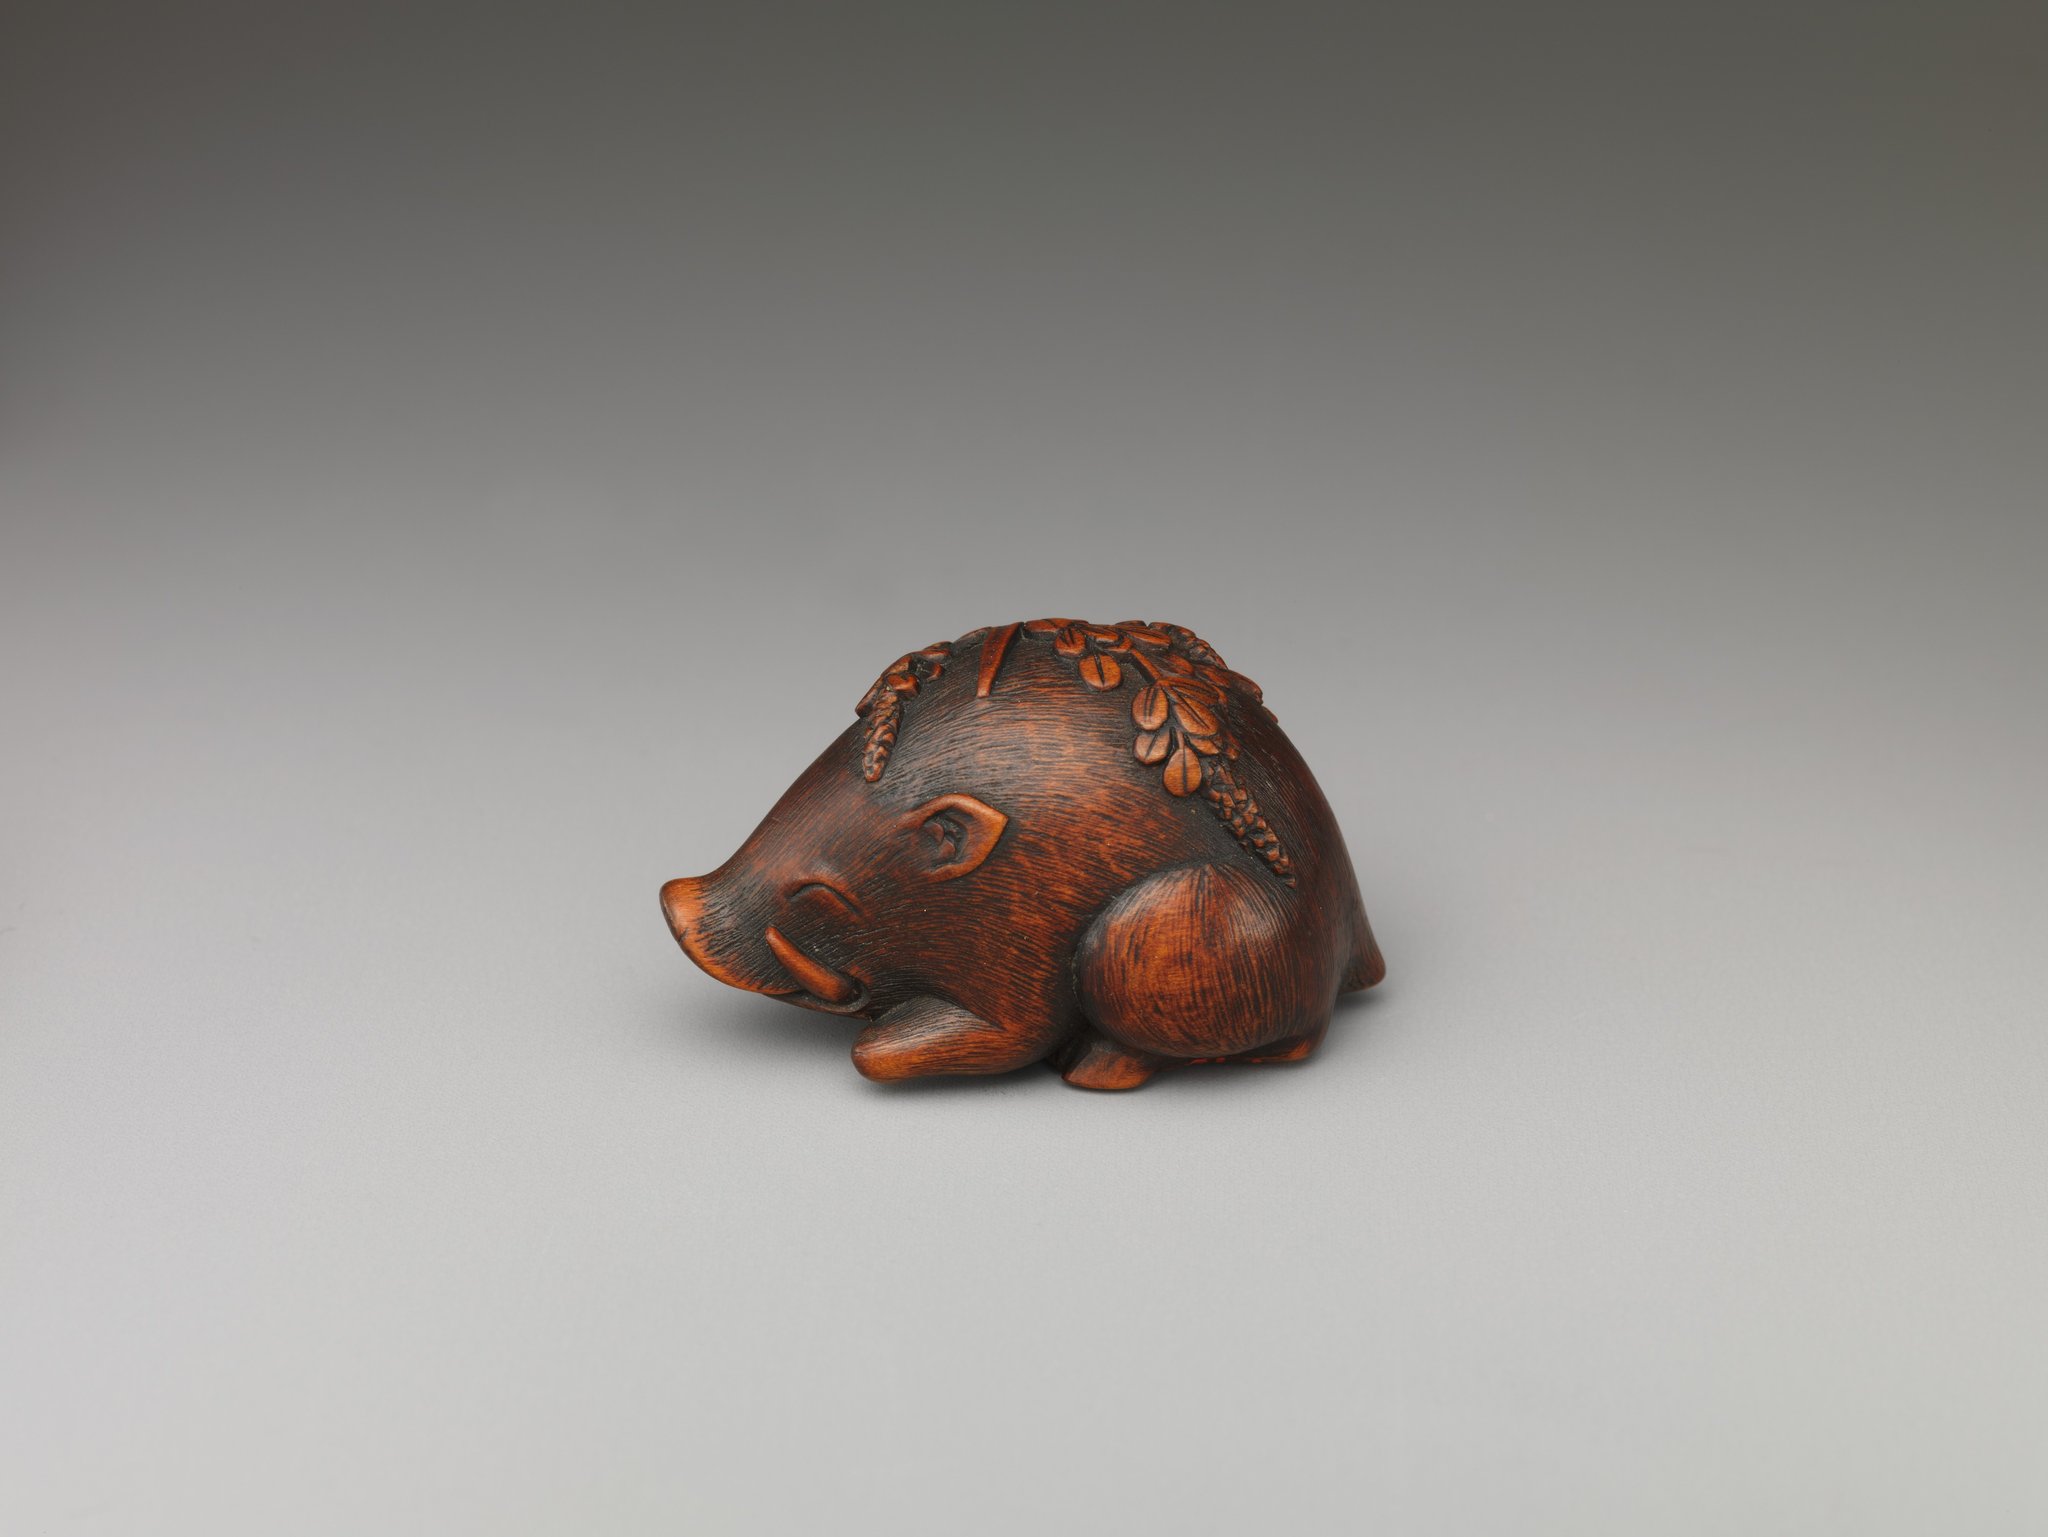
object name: netsuke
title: Boar and Grasses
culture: japanese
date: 1851-1900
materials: wood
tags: boars